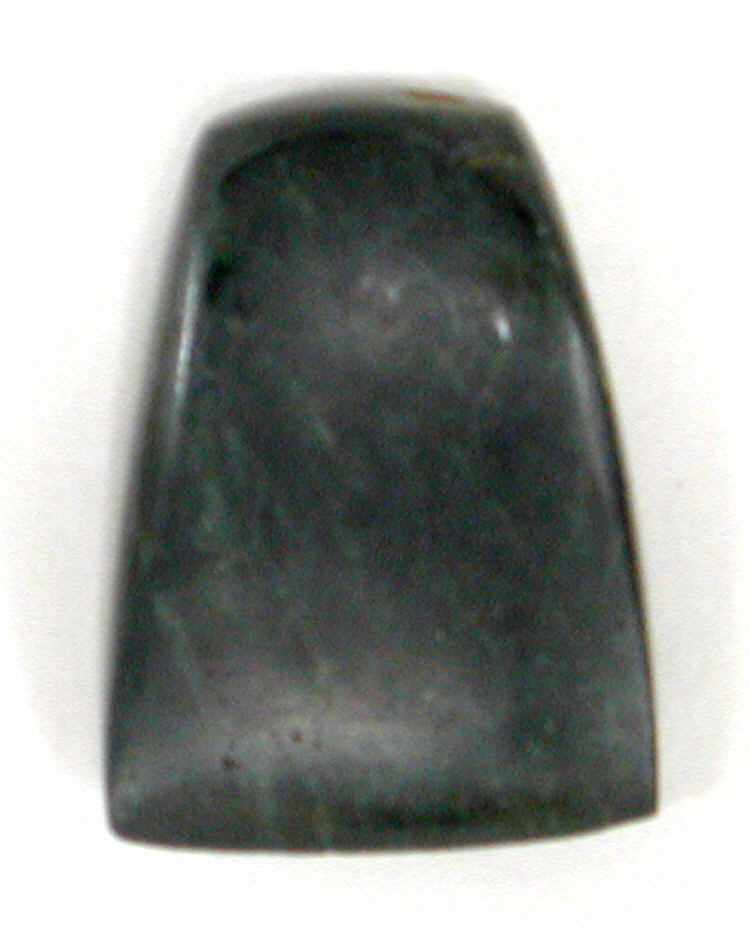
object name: celt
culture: maya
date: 1501-1600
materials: stone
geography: guatemala